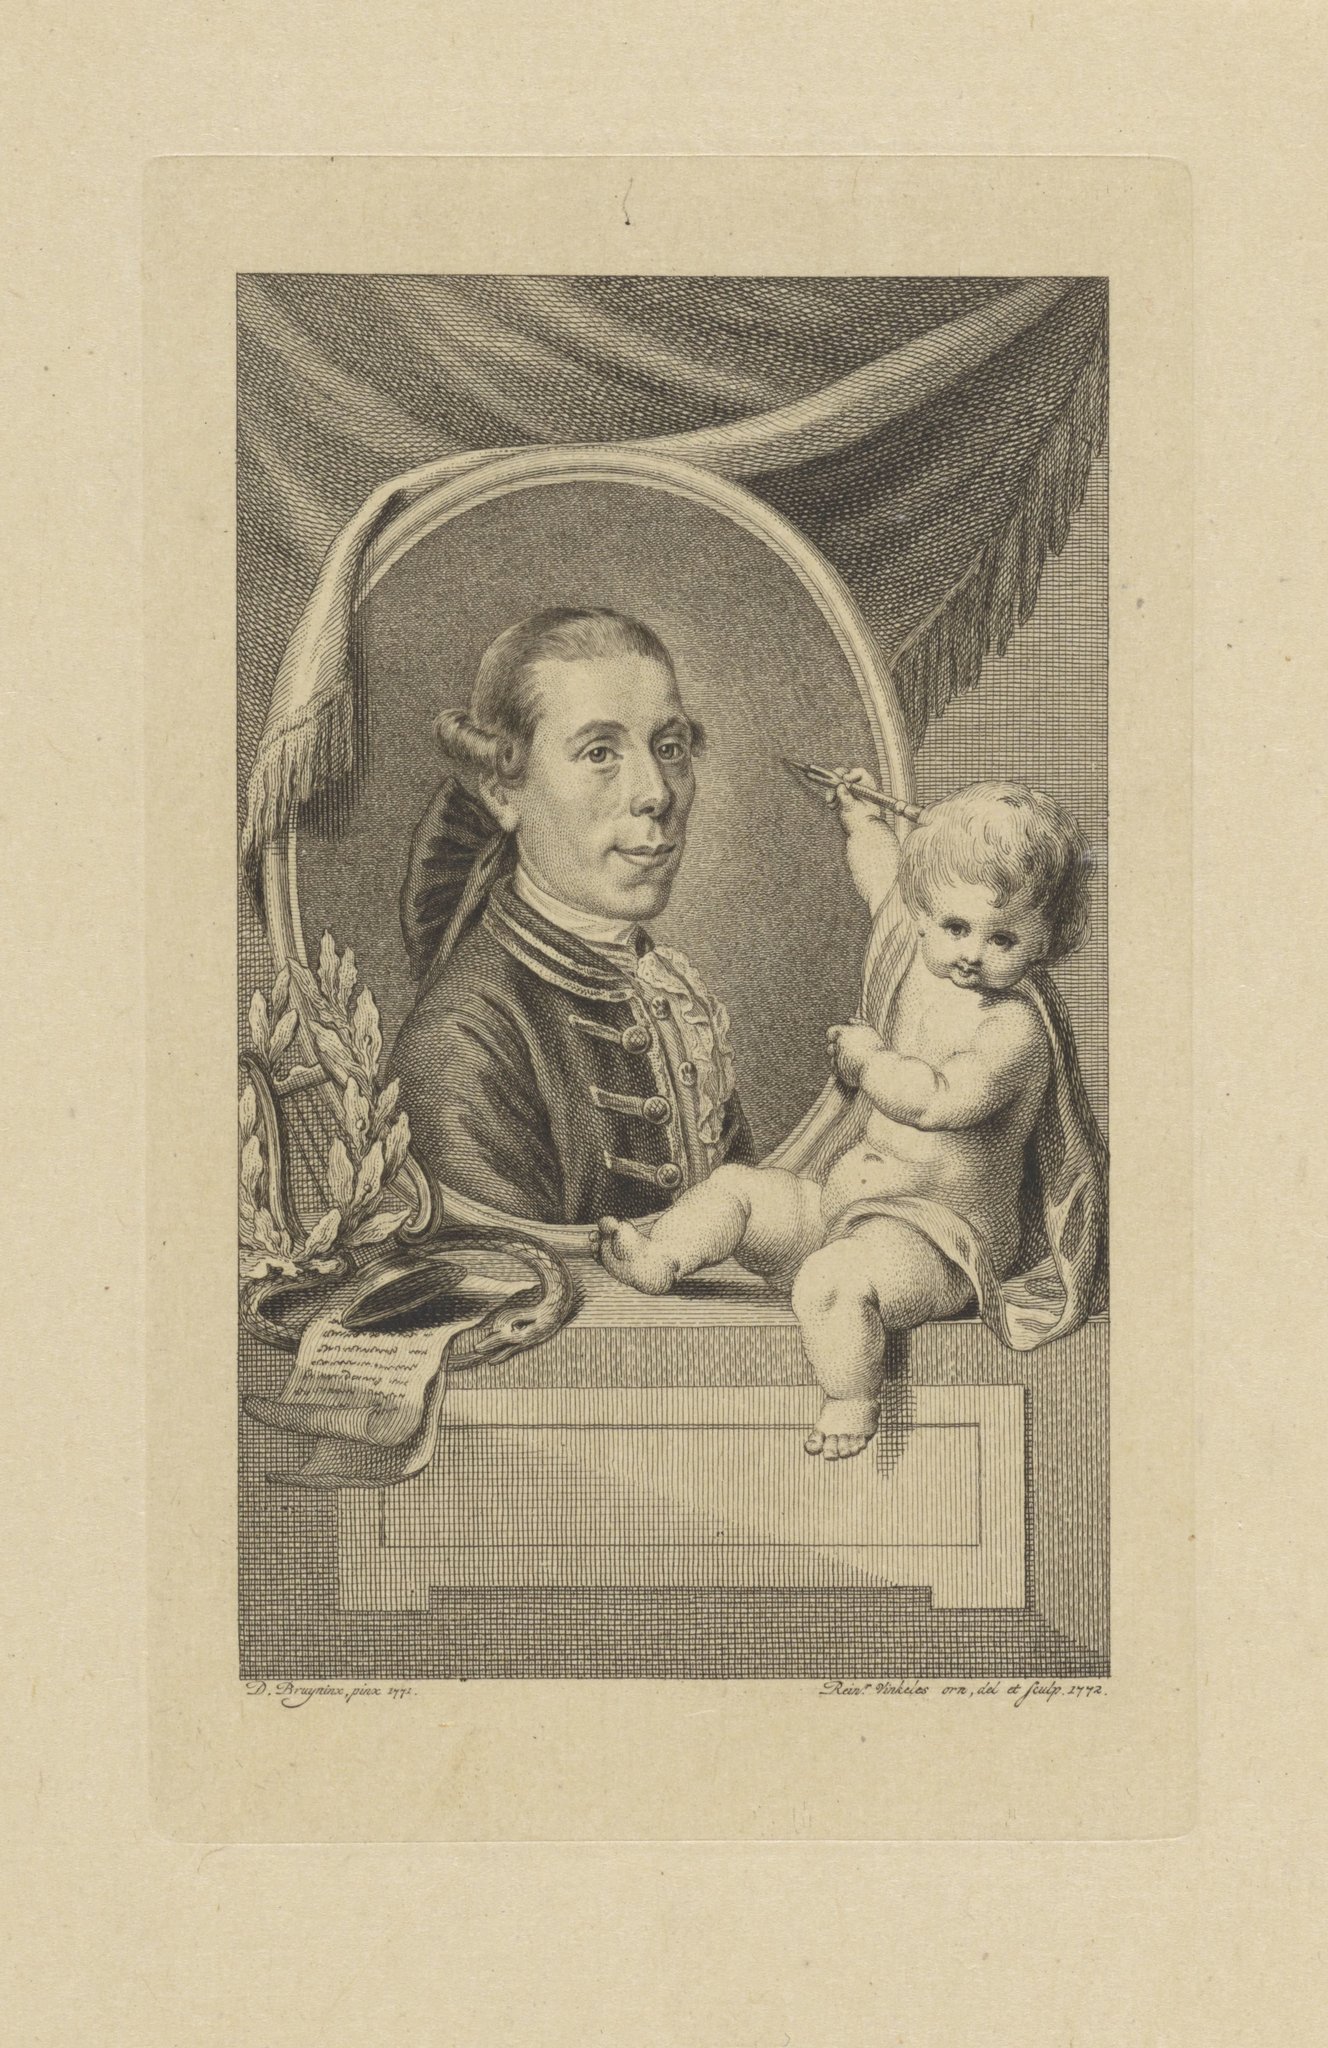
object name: print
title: Portret van Joannes Nomsz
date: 1772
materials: paper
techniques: engraving, etching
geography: amsterdam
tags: joannes nomsz, honouring the artist with laurel wreath, lyre, cithara, psaltery, tools, implements of graphic artist, serpent ouroboros, cupids: 'amores', 'amoretti', 'putti'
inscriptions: collector's mark: Lugt 240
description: Portret van Joannes Nomsz, schrijver, dichter en toneelschijver. Naast het portret en putto met een etsnaal en links een lauwerkrans, lier, beschreven vellen papier en het eeuwigheidssymbool de Ouroboros.